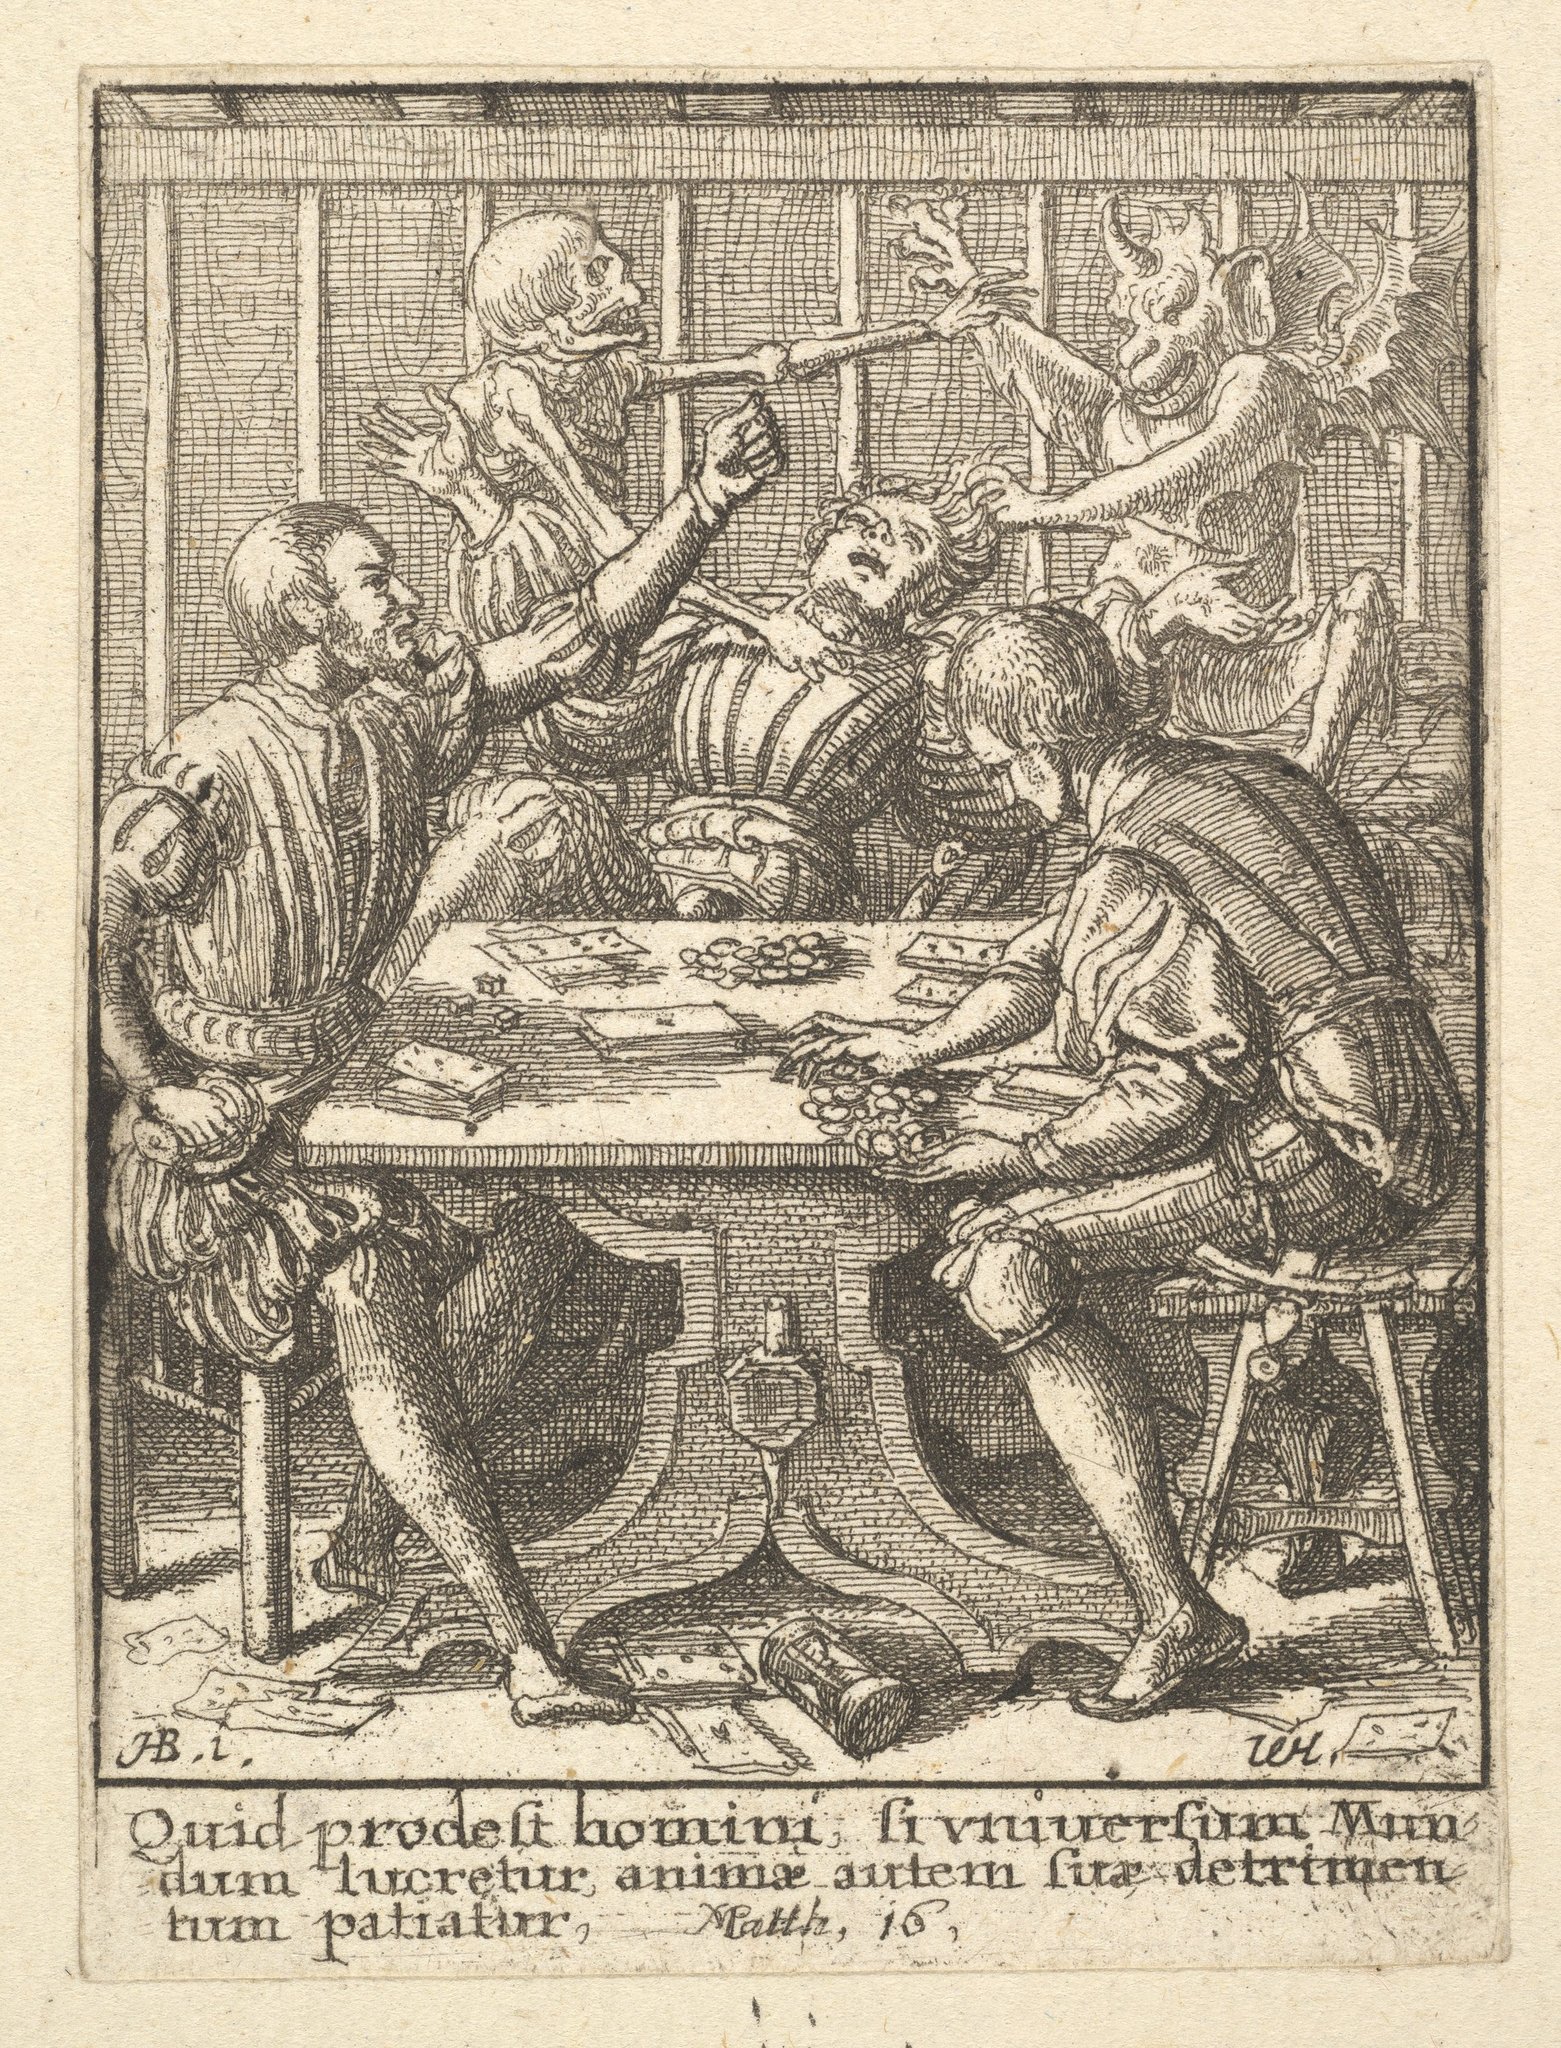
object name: print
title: The Gamesters, from the Dance of Death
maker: wenceslaus hollar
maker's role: artist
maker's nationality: bohemian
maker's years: 1607-1677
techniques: etching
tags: skeletons,men,gambling,devil